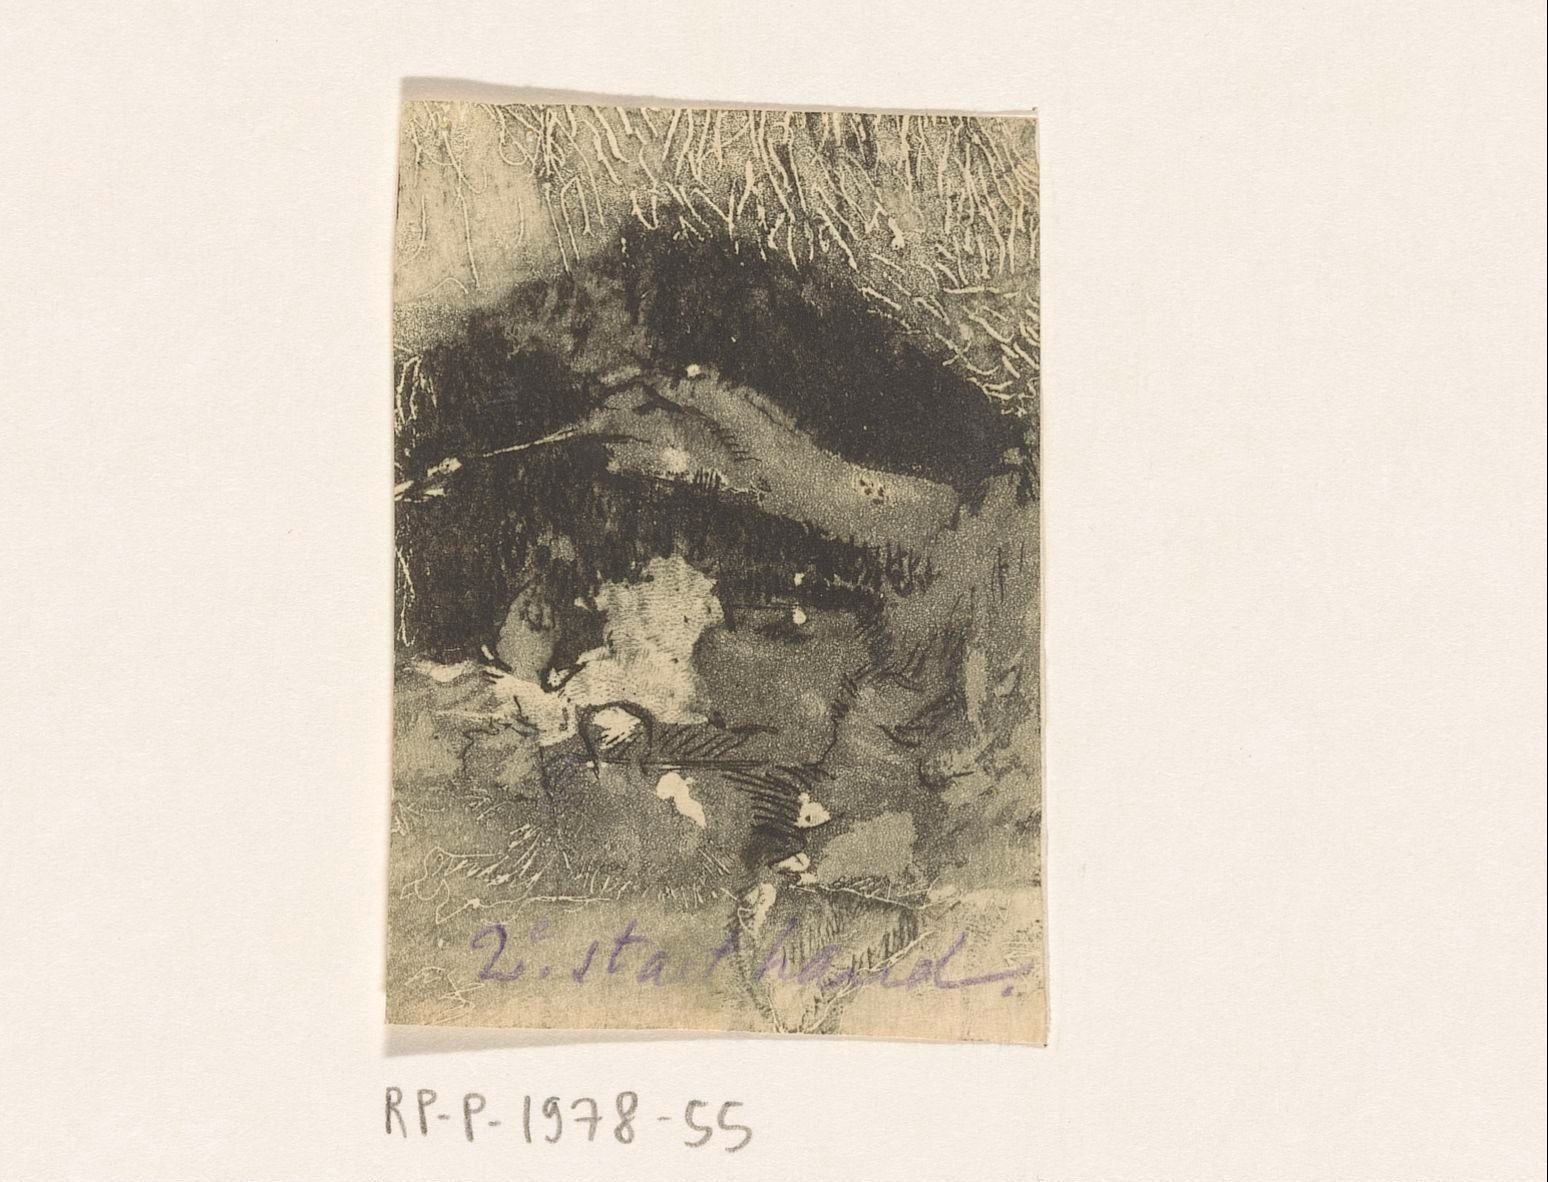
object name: print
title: Hand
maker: albert roelofs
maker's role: print maker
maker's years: 1877-1920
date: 1887-1920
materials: paper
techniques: aquatint, etching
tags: hand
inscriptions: collector's mark: Lugt 2228, collector's mark: Lugt 2760, number: ‘1219 / 21’